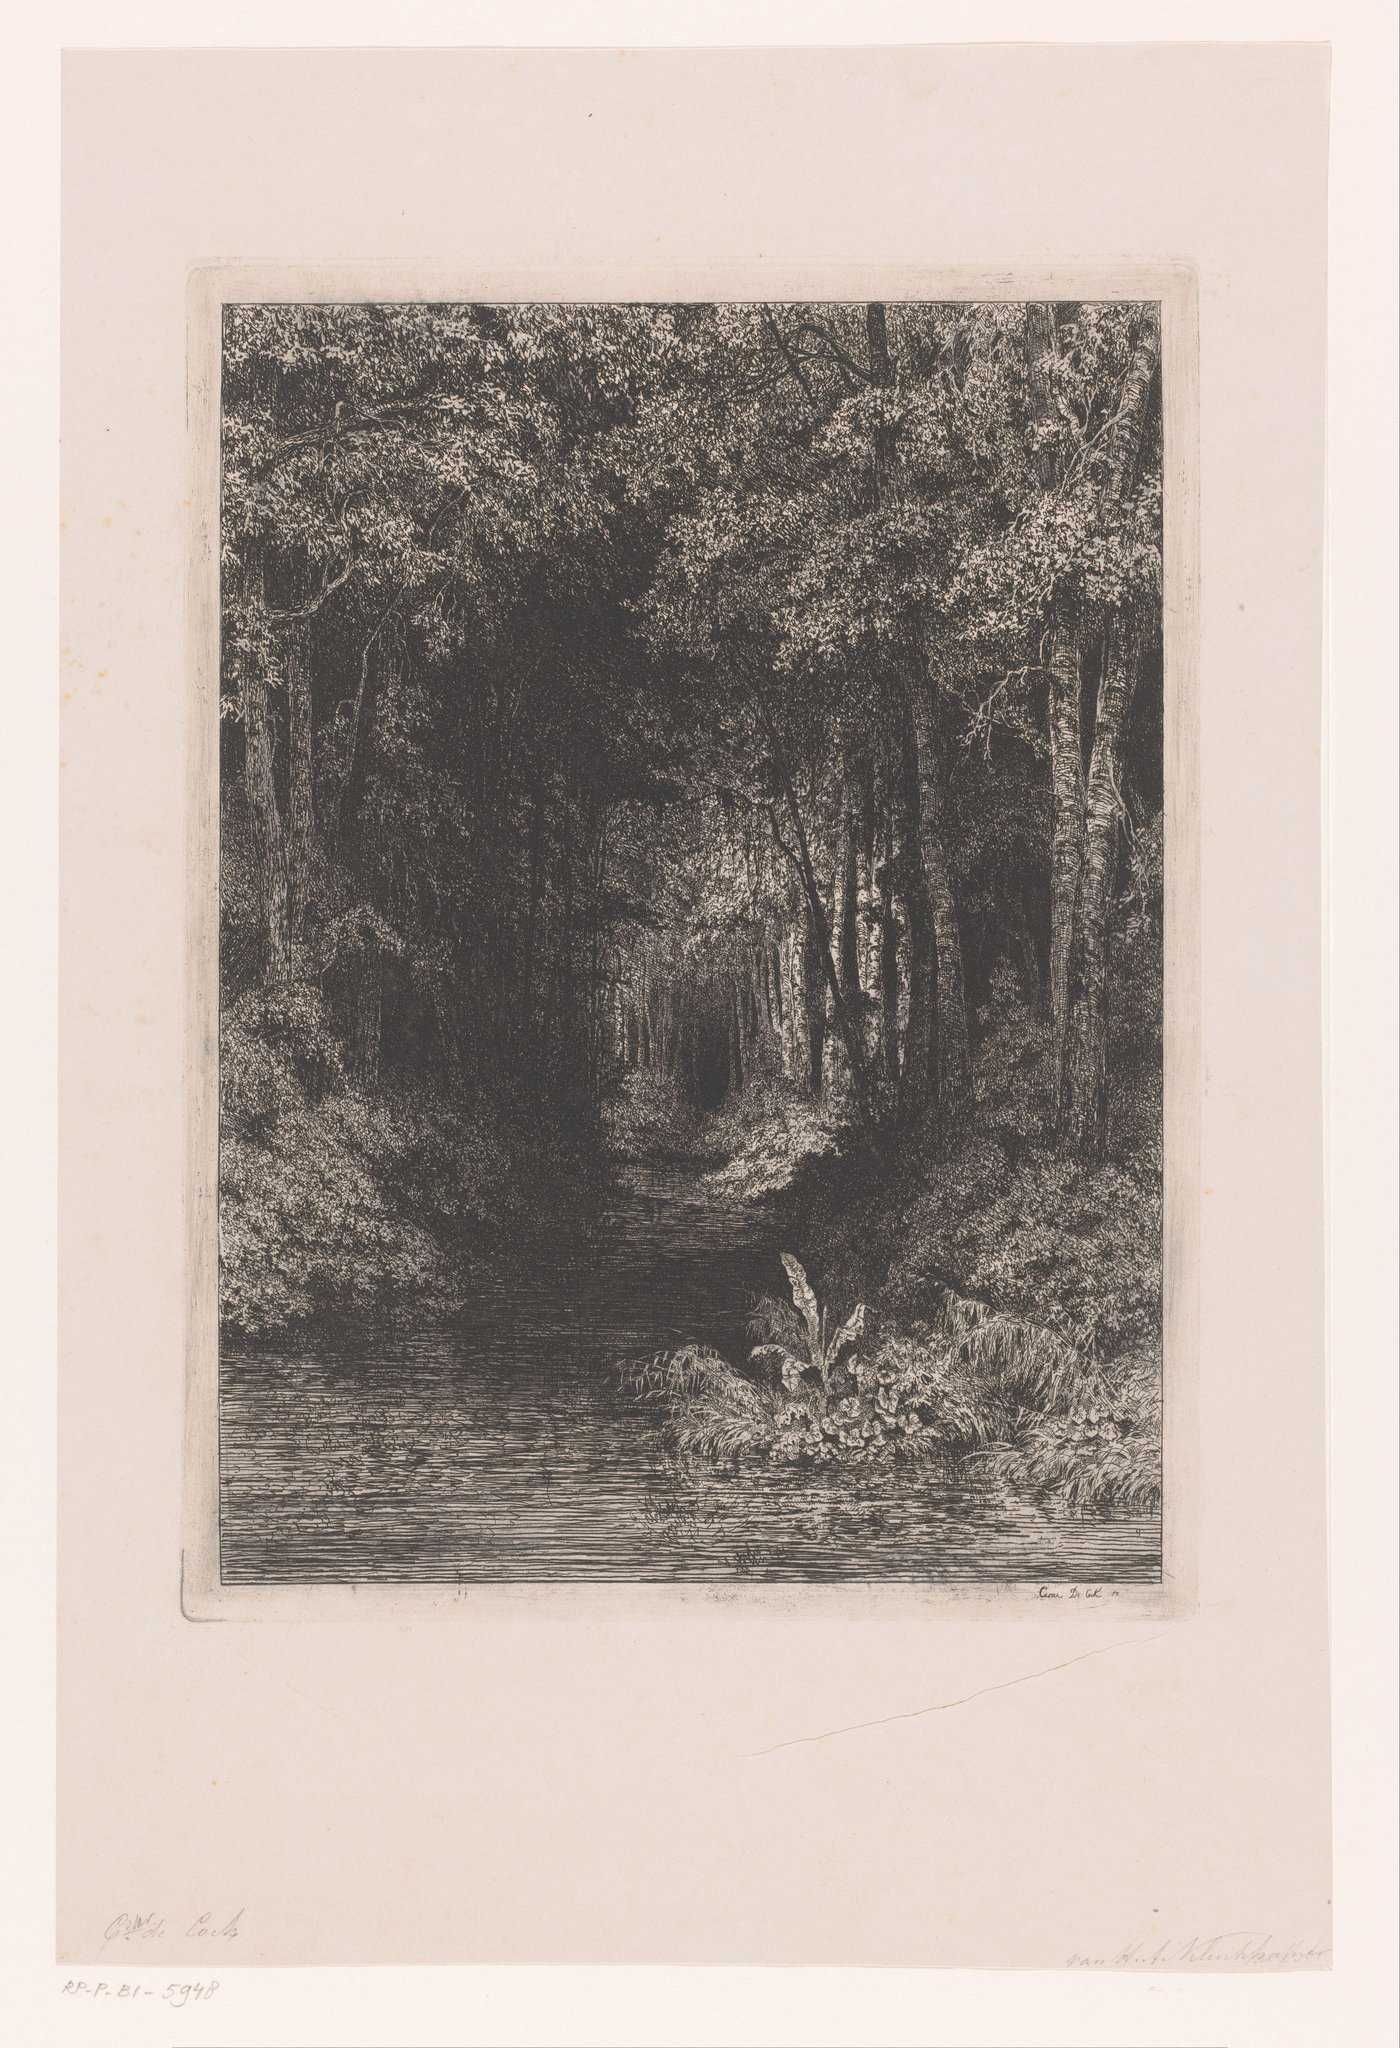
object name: print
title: Beek door het bos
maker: césar de cock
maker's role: print maker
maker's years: 1823-1904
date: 1833-1879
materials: paper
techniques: etching, roulette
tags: river, forest, wood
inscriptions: collector's mark: Lugt 2165